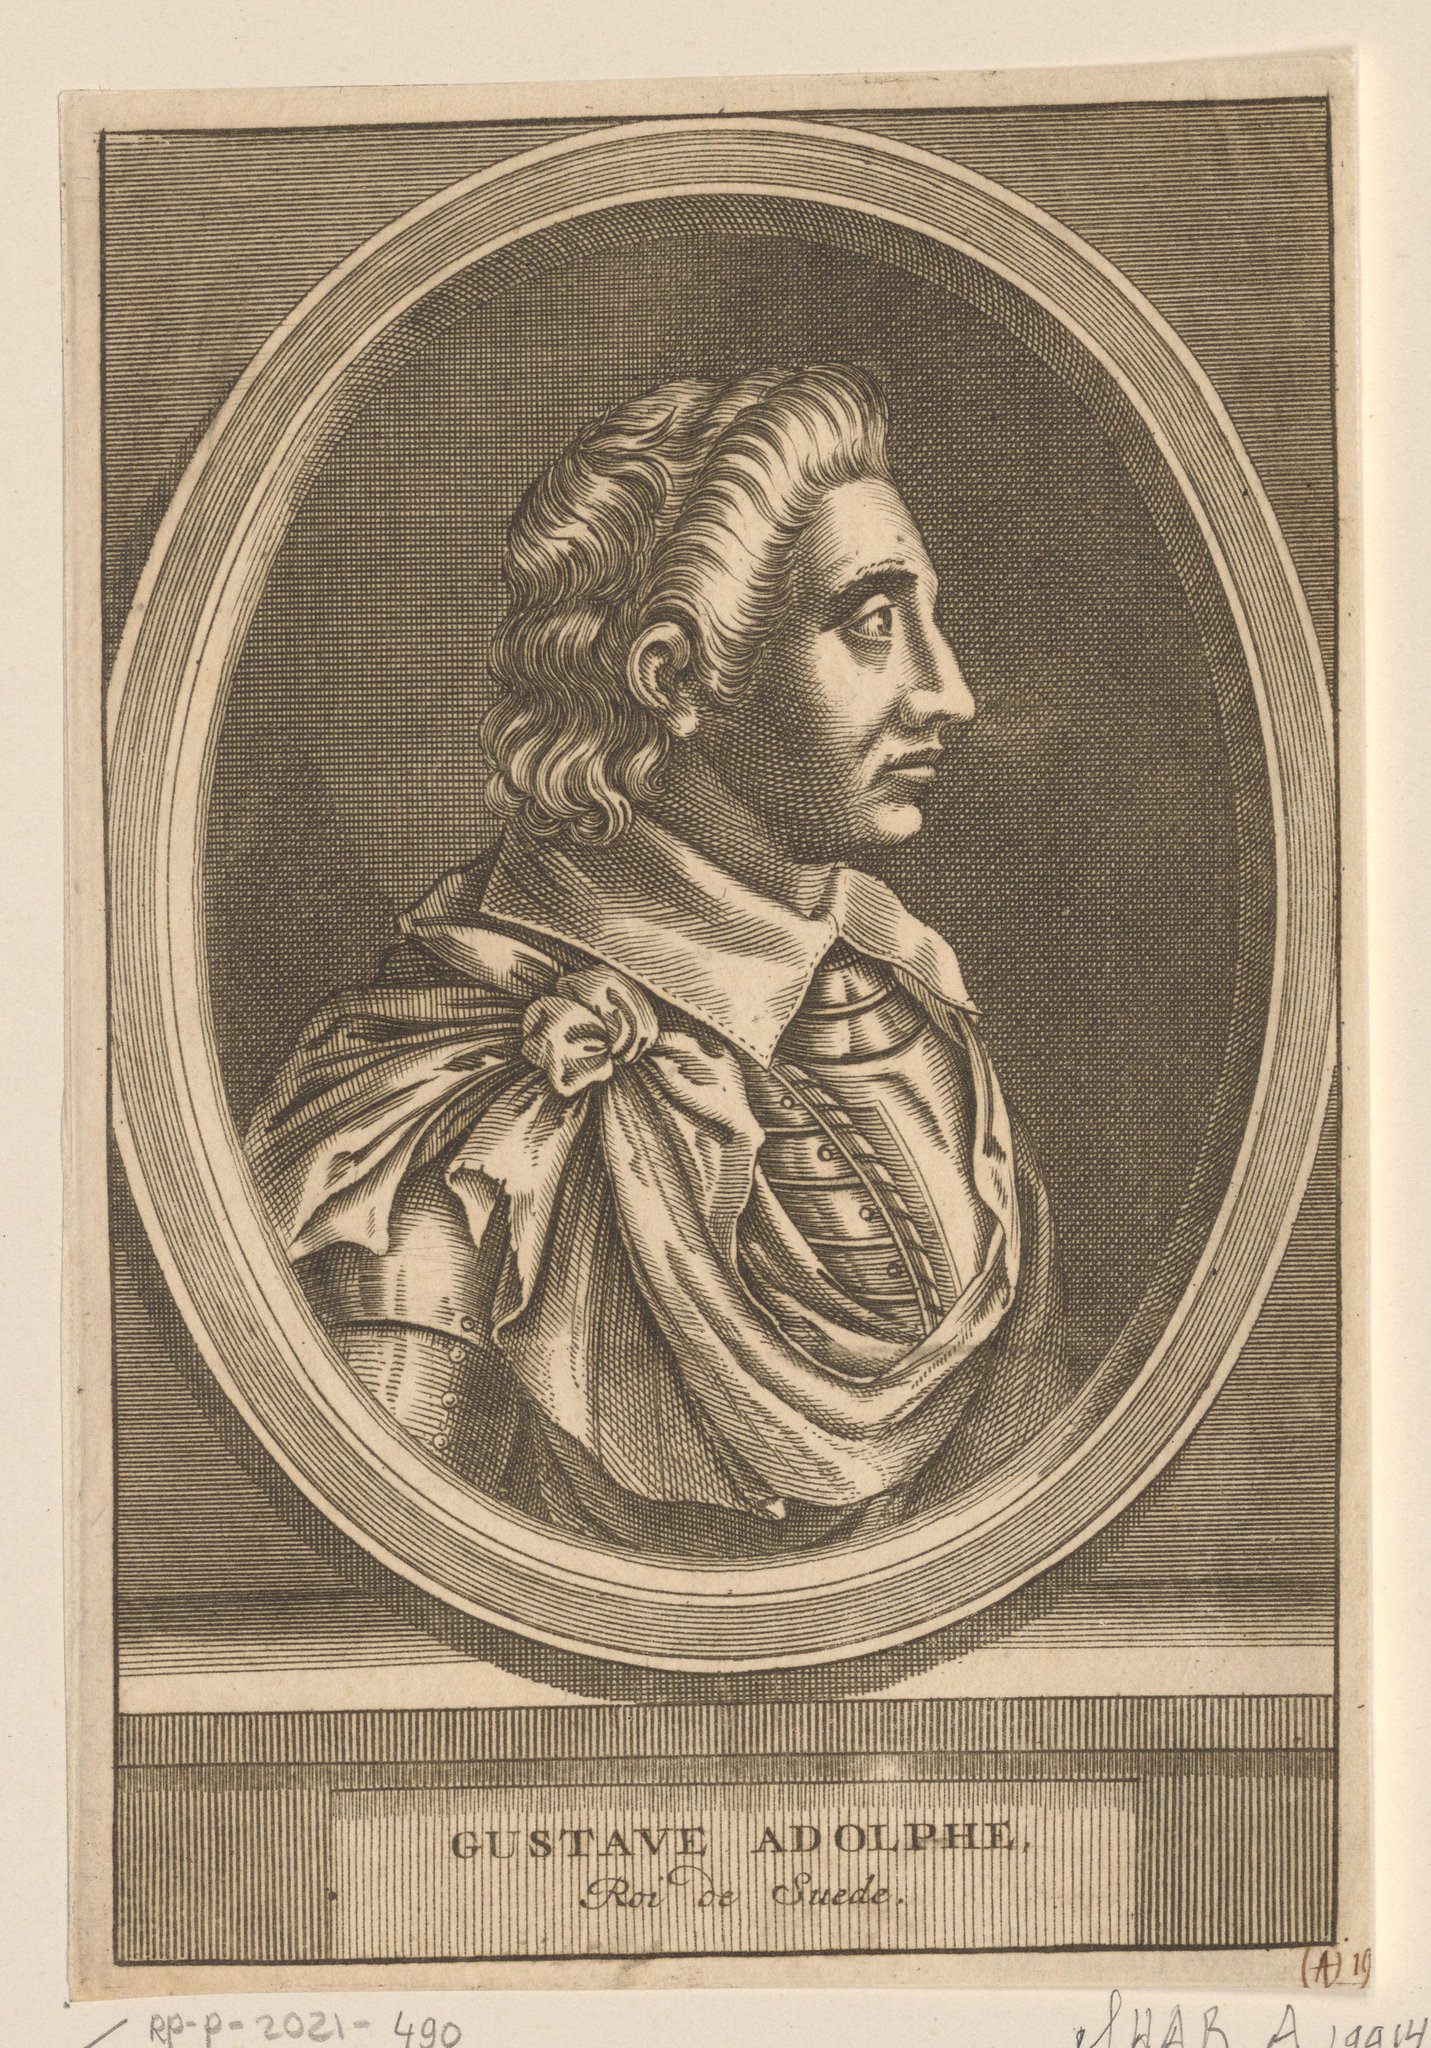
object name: print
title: Portret van Gustaaf II, koning van Zweden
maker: Anonymous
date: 1611-1711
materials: paper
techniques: engraving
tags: historical persons, king